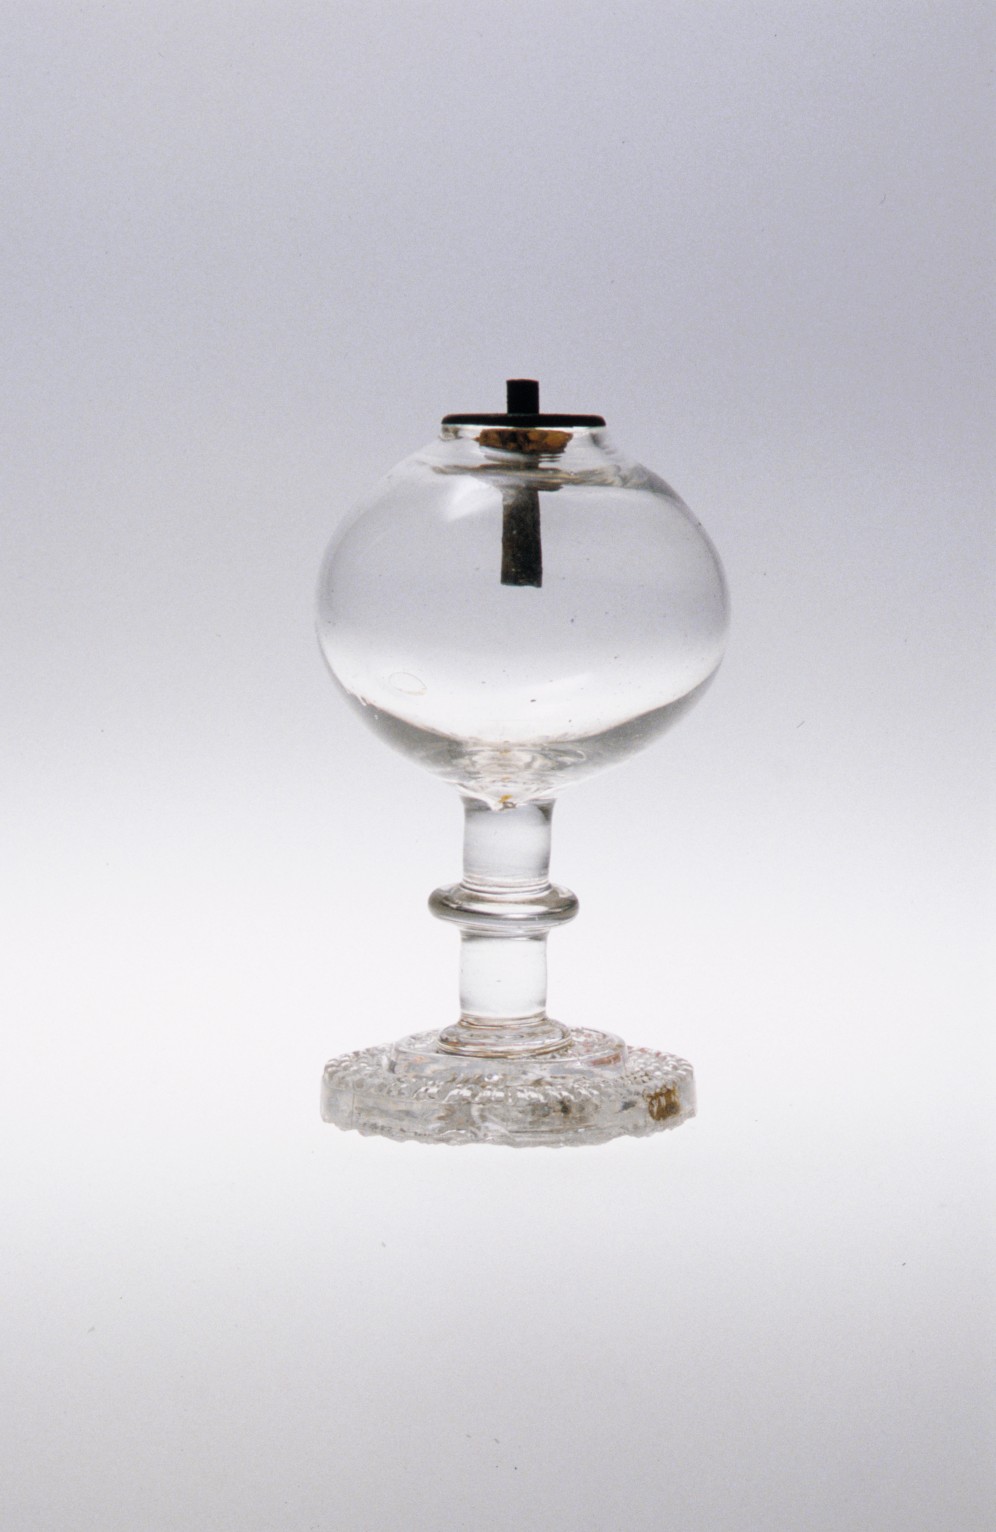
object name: whale oil lamp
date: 1827-1835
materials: glass, lead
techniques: glassblowing, pressed